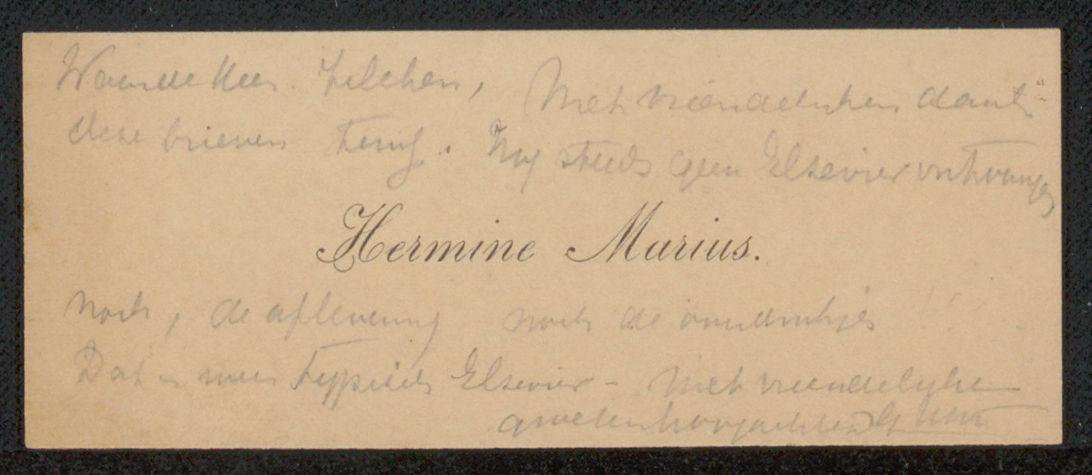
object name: visiting card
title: Visitekaartje aan Philip Zilcken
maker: grada hermina marius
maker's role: painter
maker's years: 1854-1919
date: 1864-1919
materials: cardboard, pencil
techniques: printing, writing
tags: the hague, painter, philip zilcken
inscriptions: collector's mark: ‘RPK’